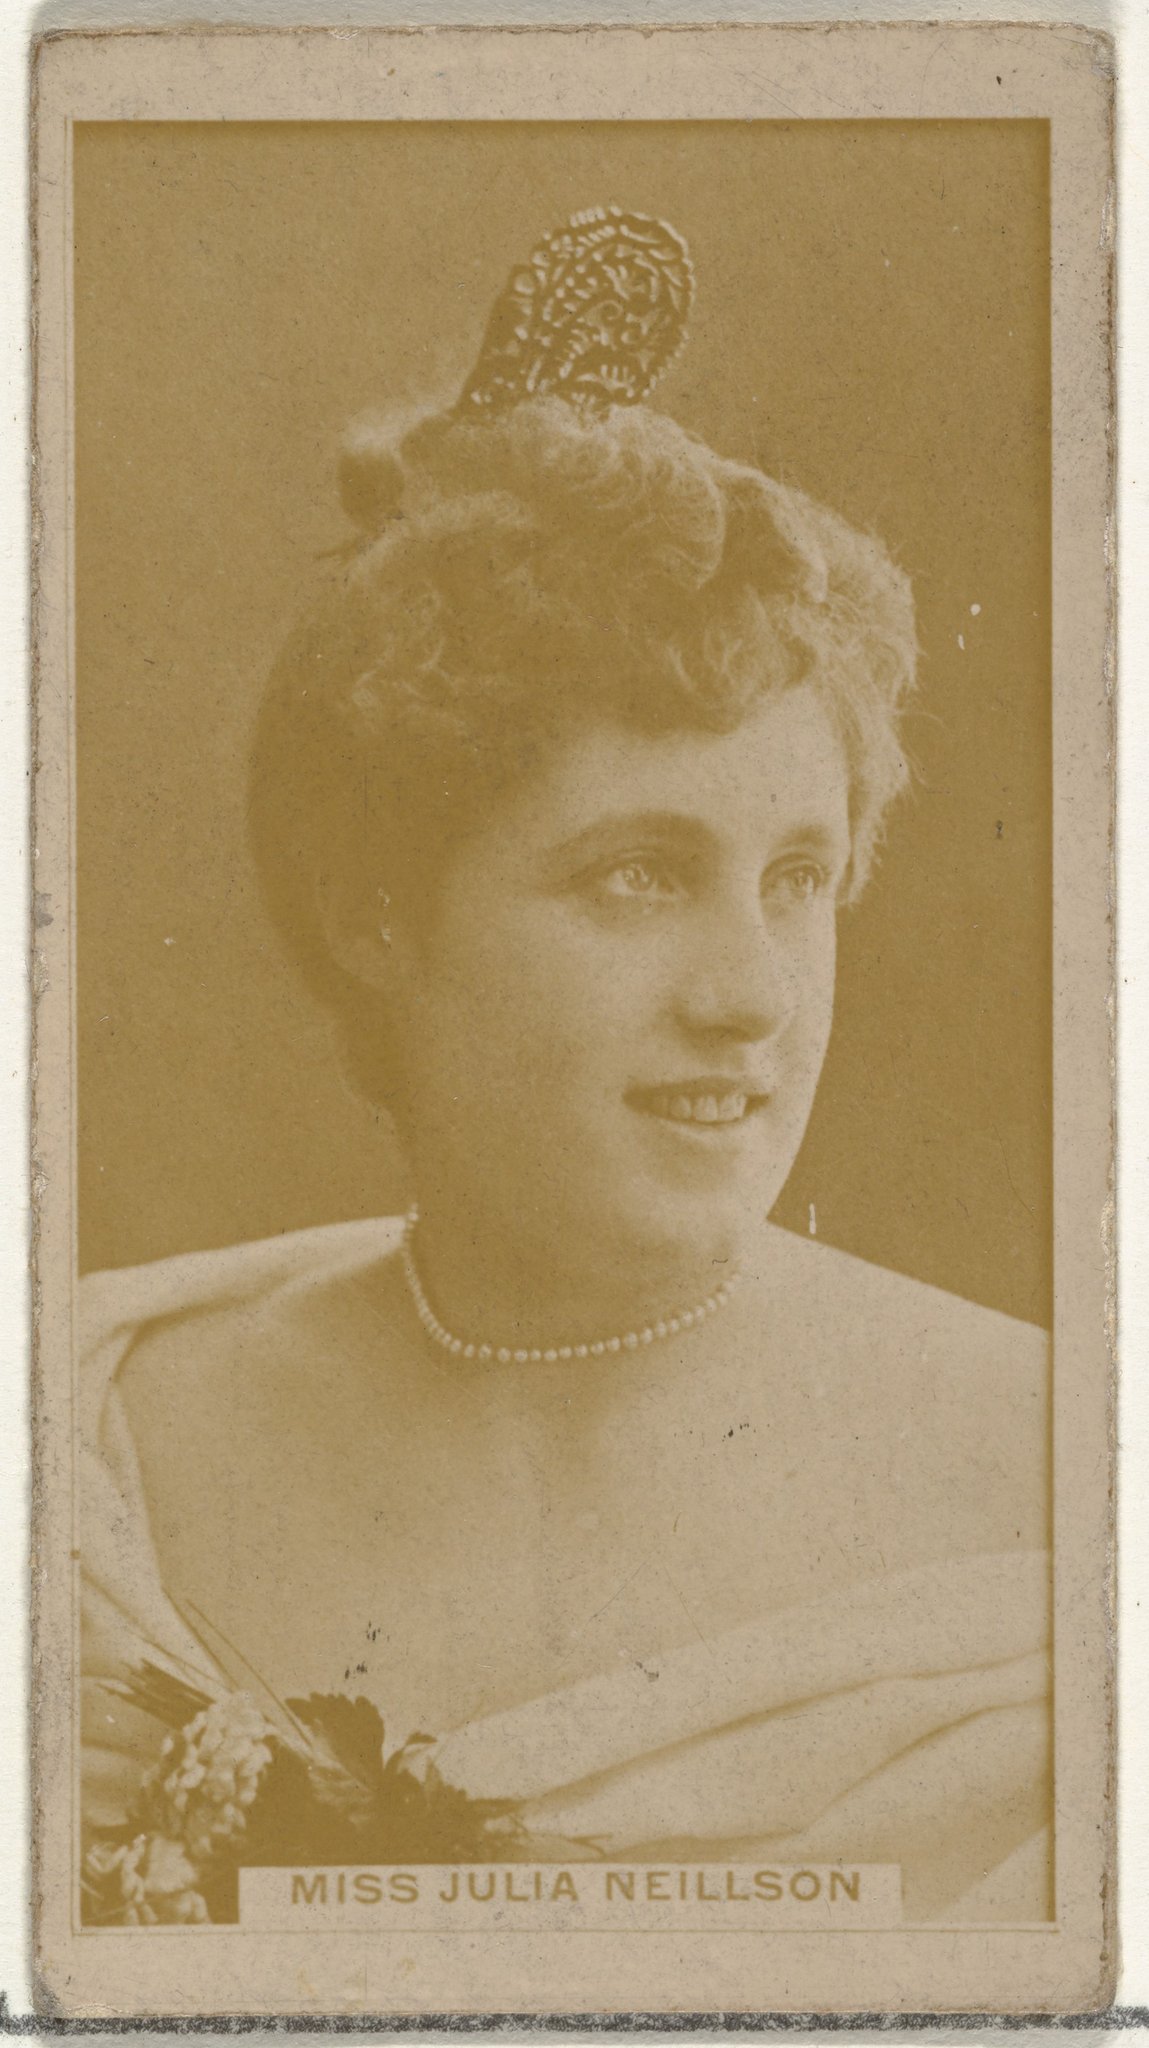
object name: photograph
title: Miss Julia Neillson, from the Actors and Actresses series (N145-8) issued by Duke Sons & Co. to promote Duke Cigarettes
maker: w. duke, sons & co.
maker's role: publisher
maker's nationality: american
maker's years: 1870-1920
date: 1891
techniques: albumen silver print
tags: portraits,women,actresses